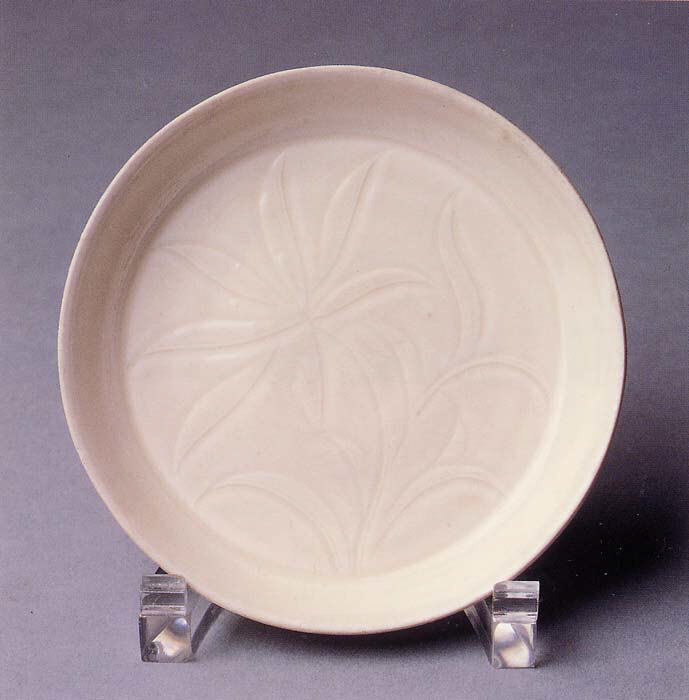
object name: dish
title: Dish with floral decoration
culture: chinese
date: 1101-1200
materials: glaze, ivory, porcelain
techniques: incising